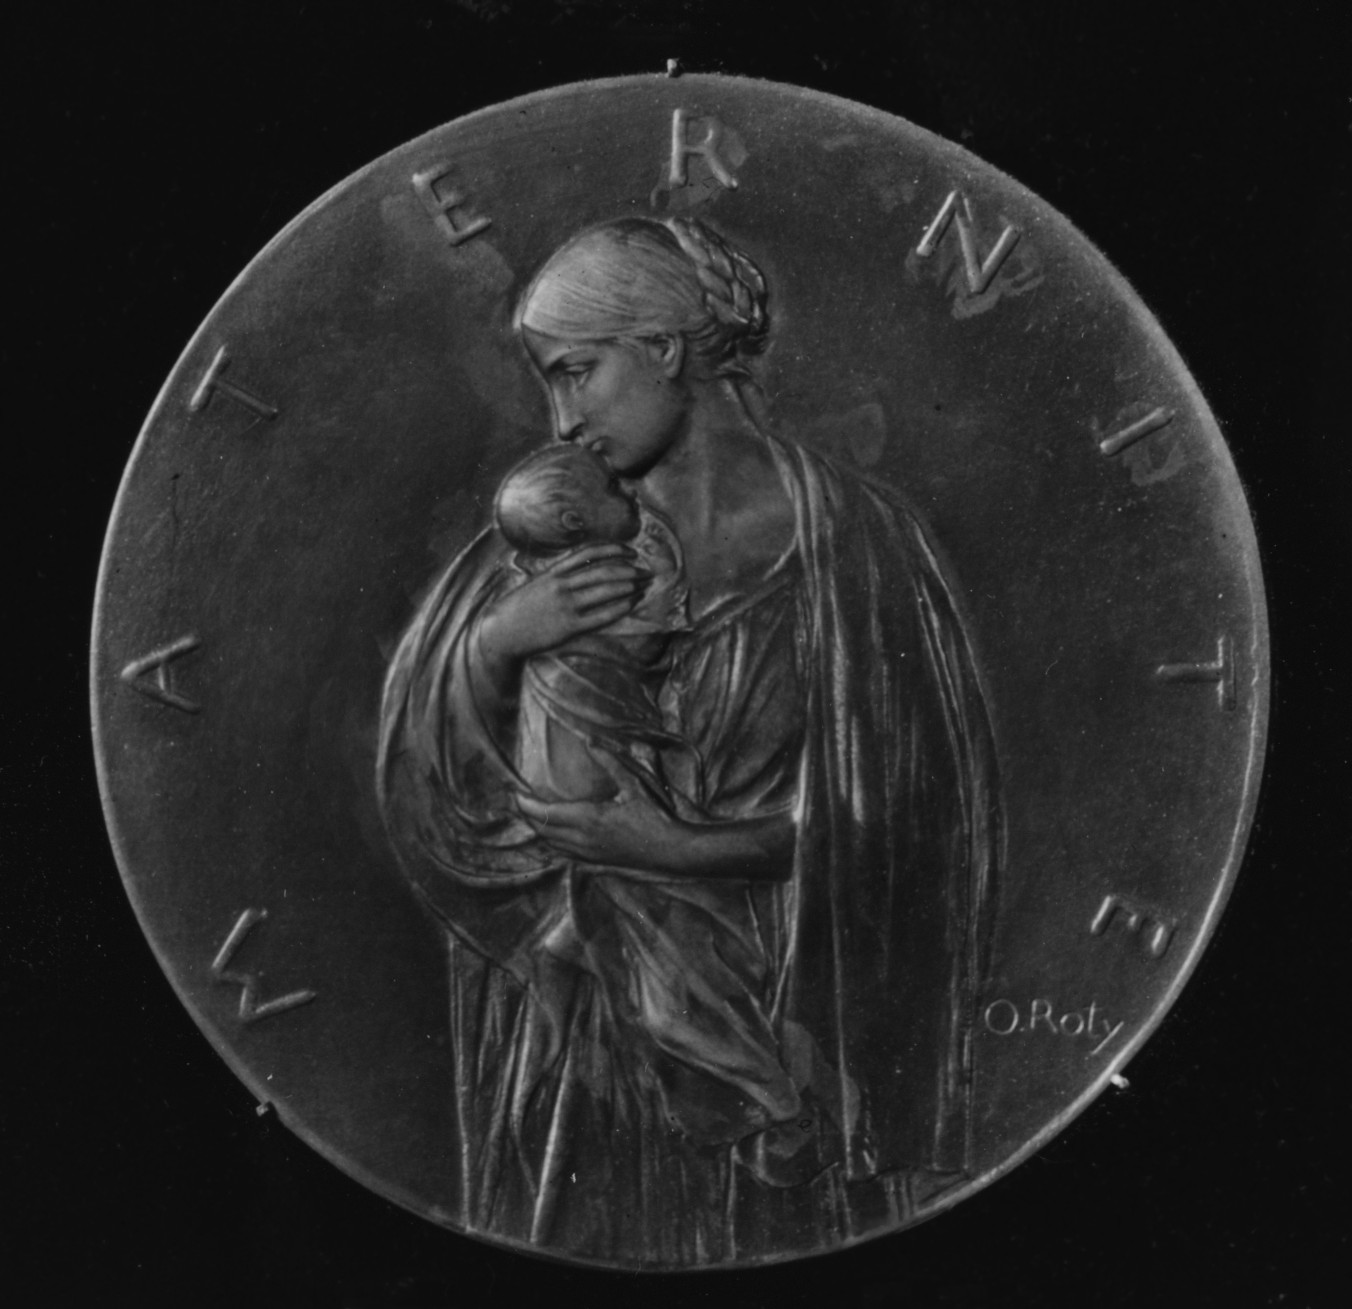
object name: medallion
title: Memorial of Baptism of the Artist's Son, Jean Georges Emile Roty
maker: louis-oscar roty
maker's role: artist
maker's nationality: french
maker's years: 1846-1911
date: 1893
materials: bronze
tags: infants,mothers